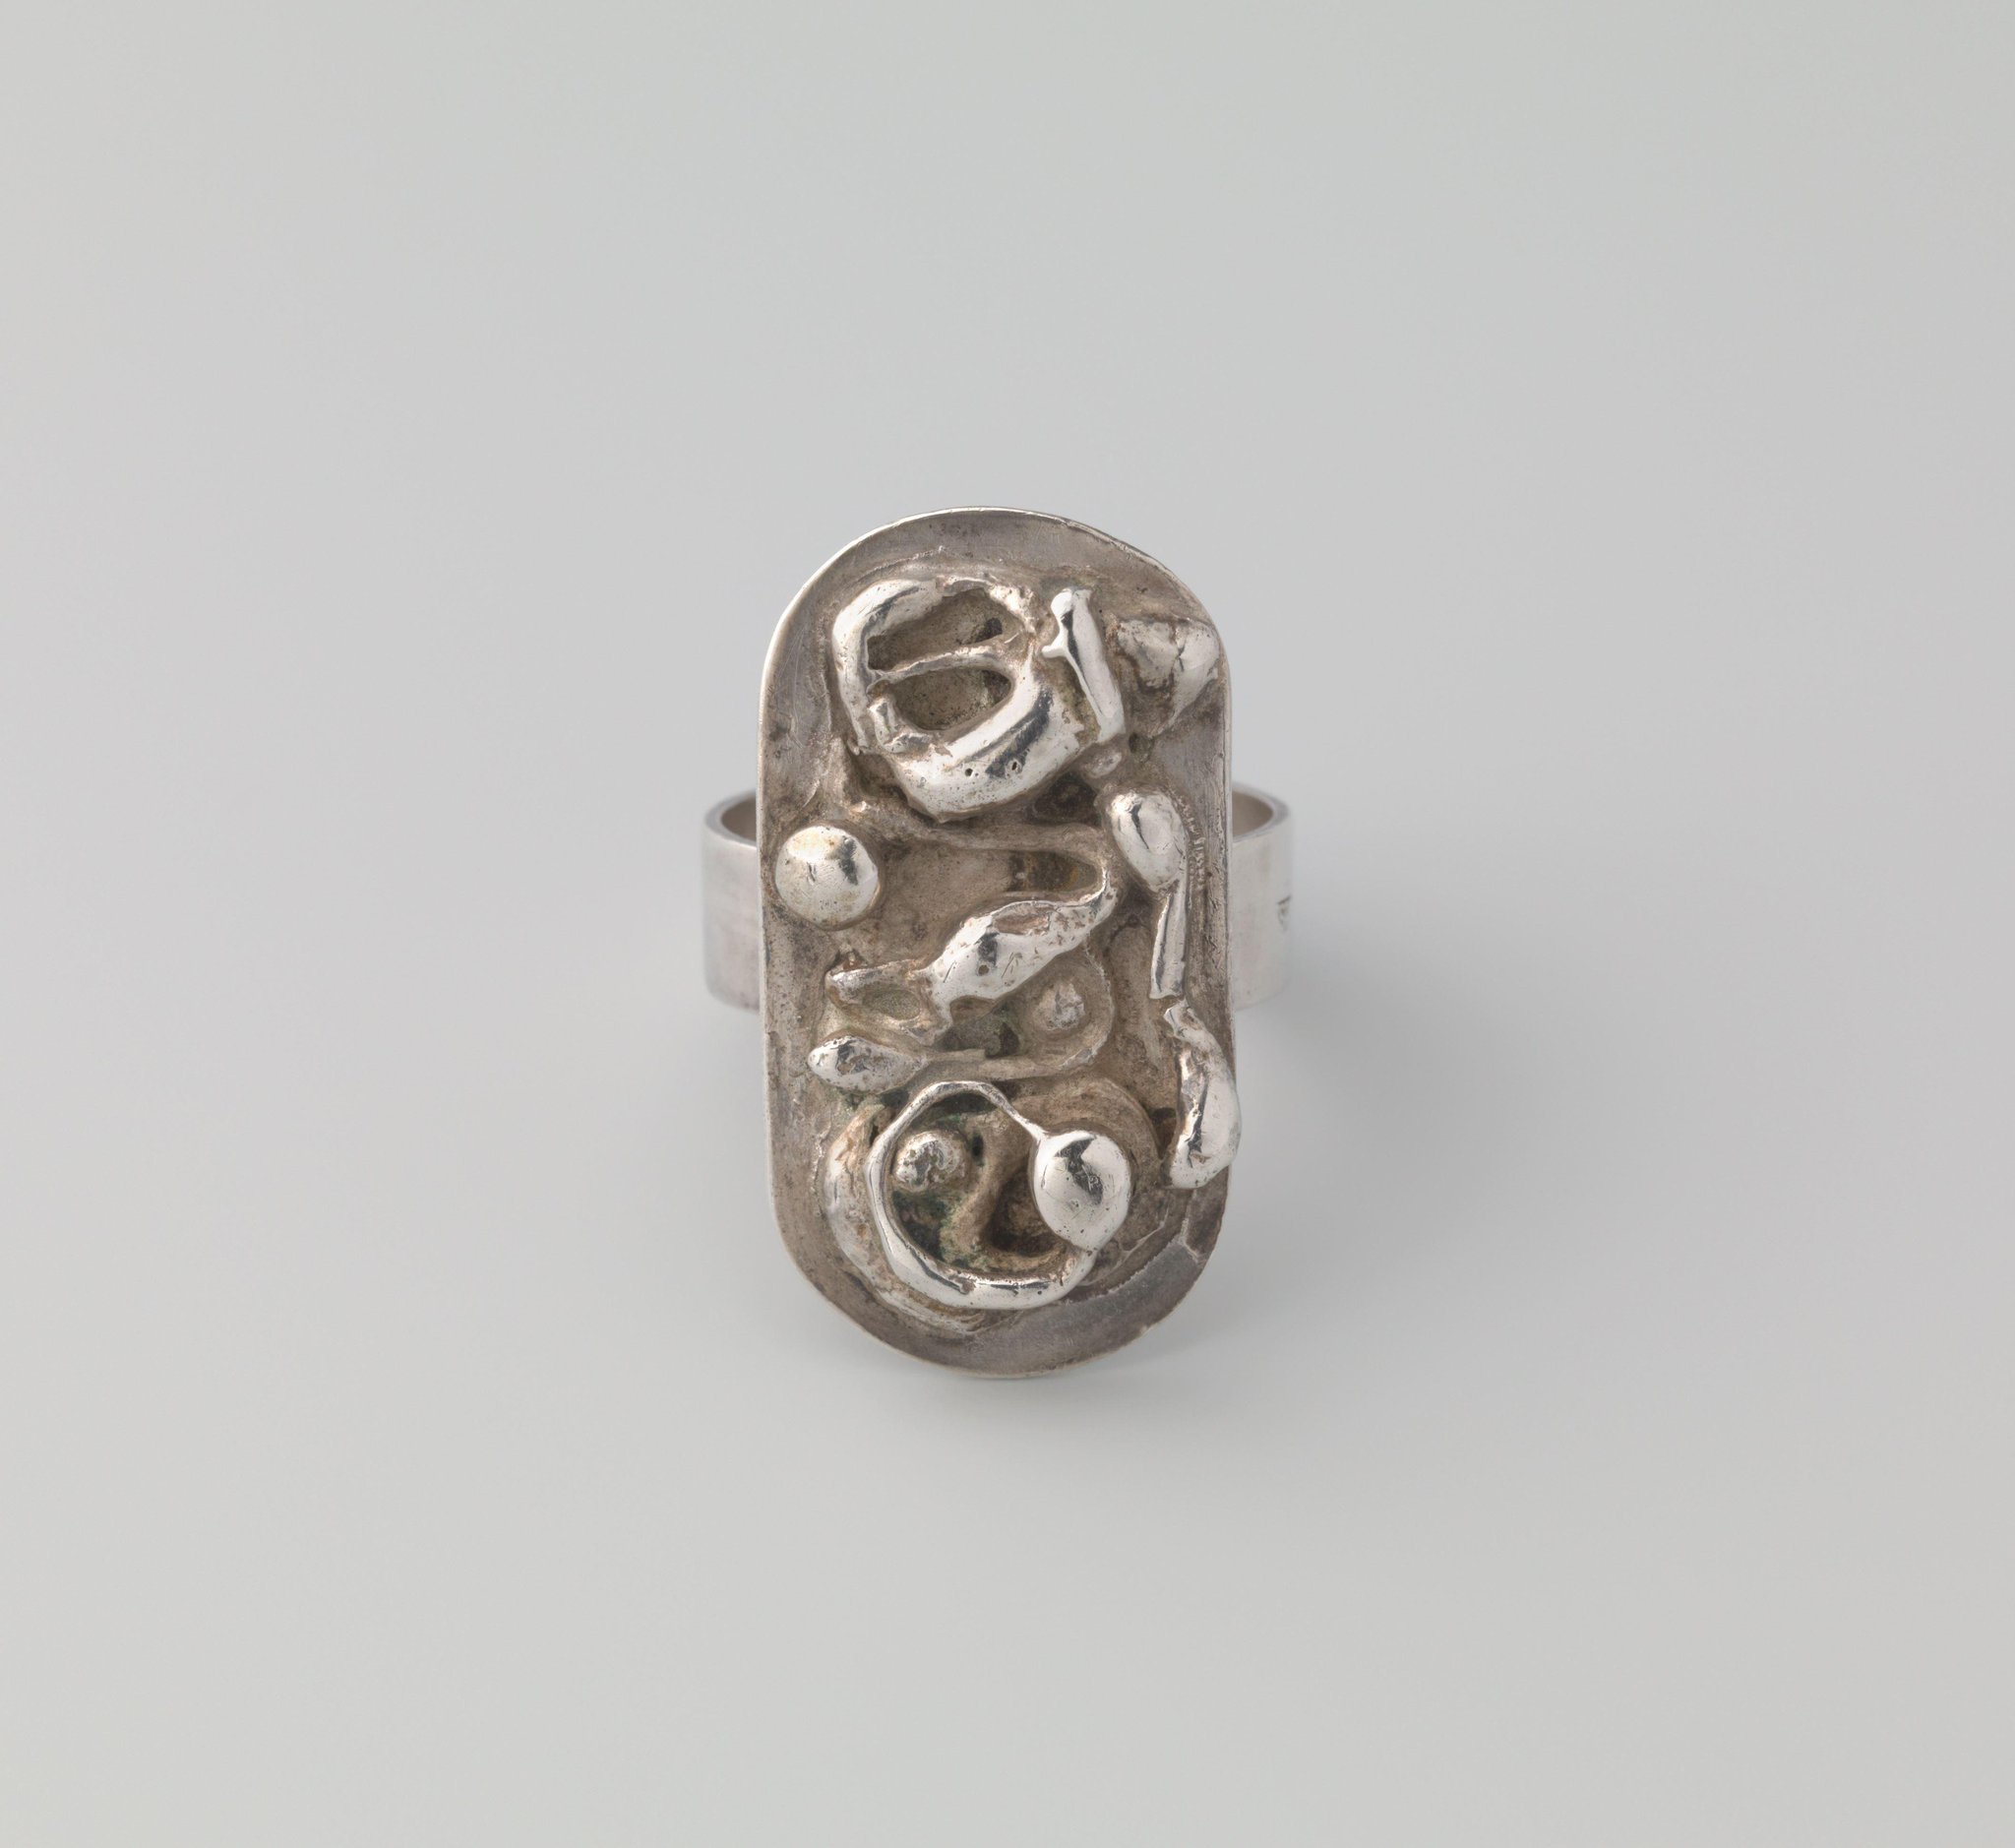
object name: ring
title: Tienerring met ovale plaat voorzien van reliëf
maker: Anonymous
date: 1960-1970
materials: silver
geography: groningen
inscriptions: import mark: ‘Z2’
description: Tienerring van zilver met ovale plaat voorzien van reliëf.